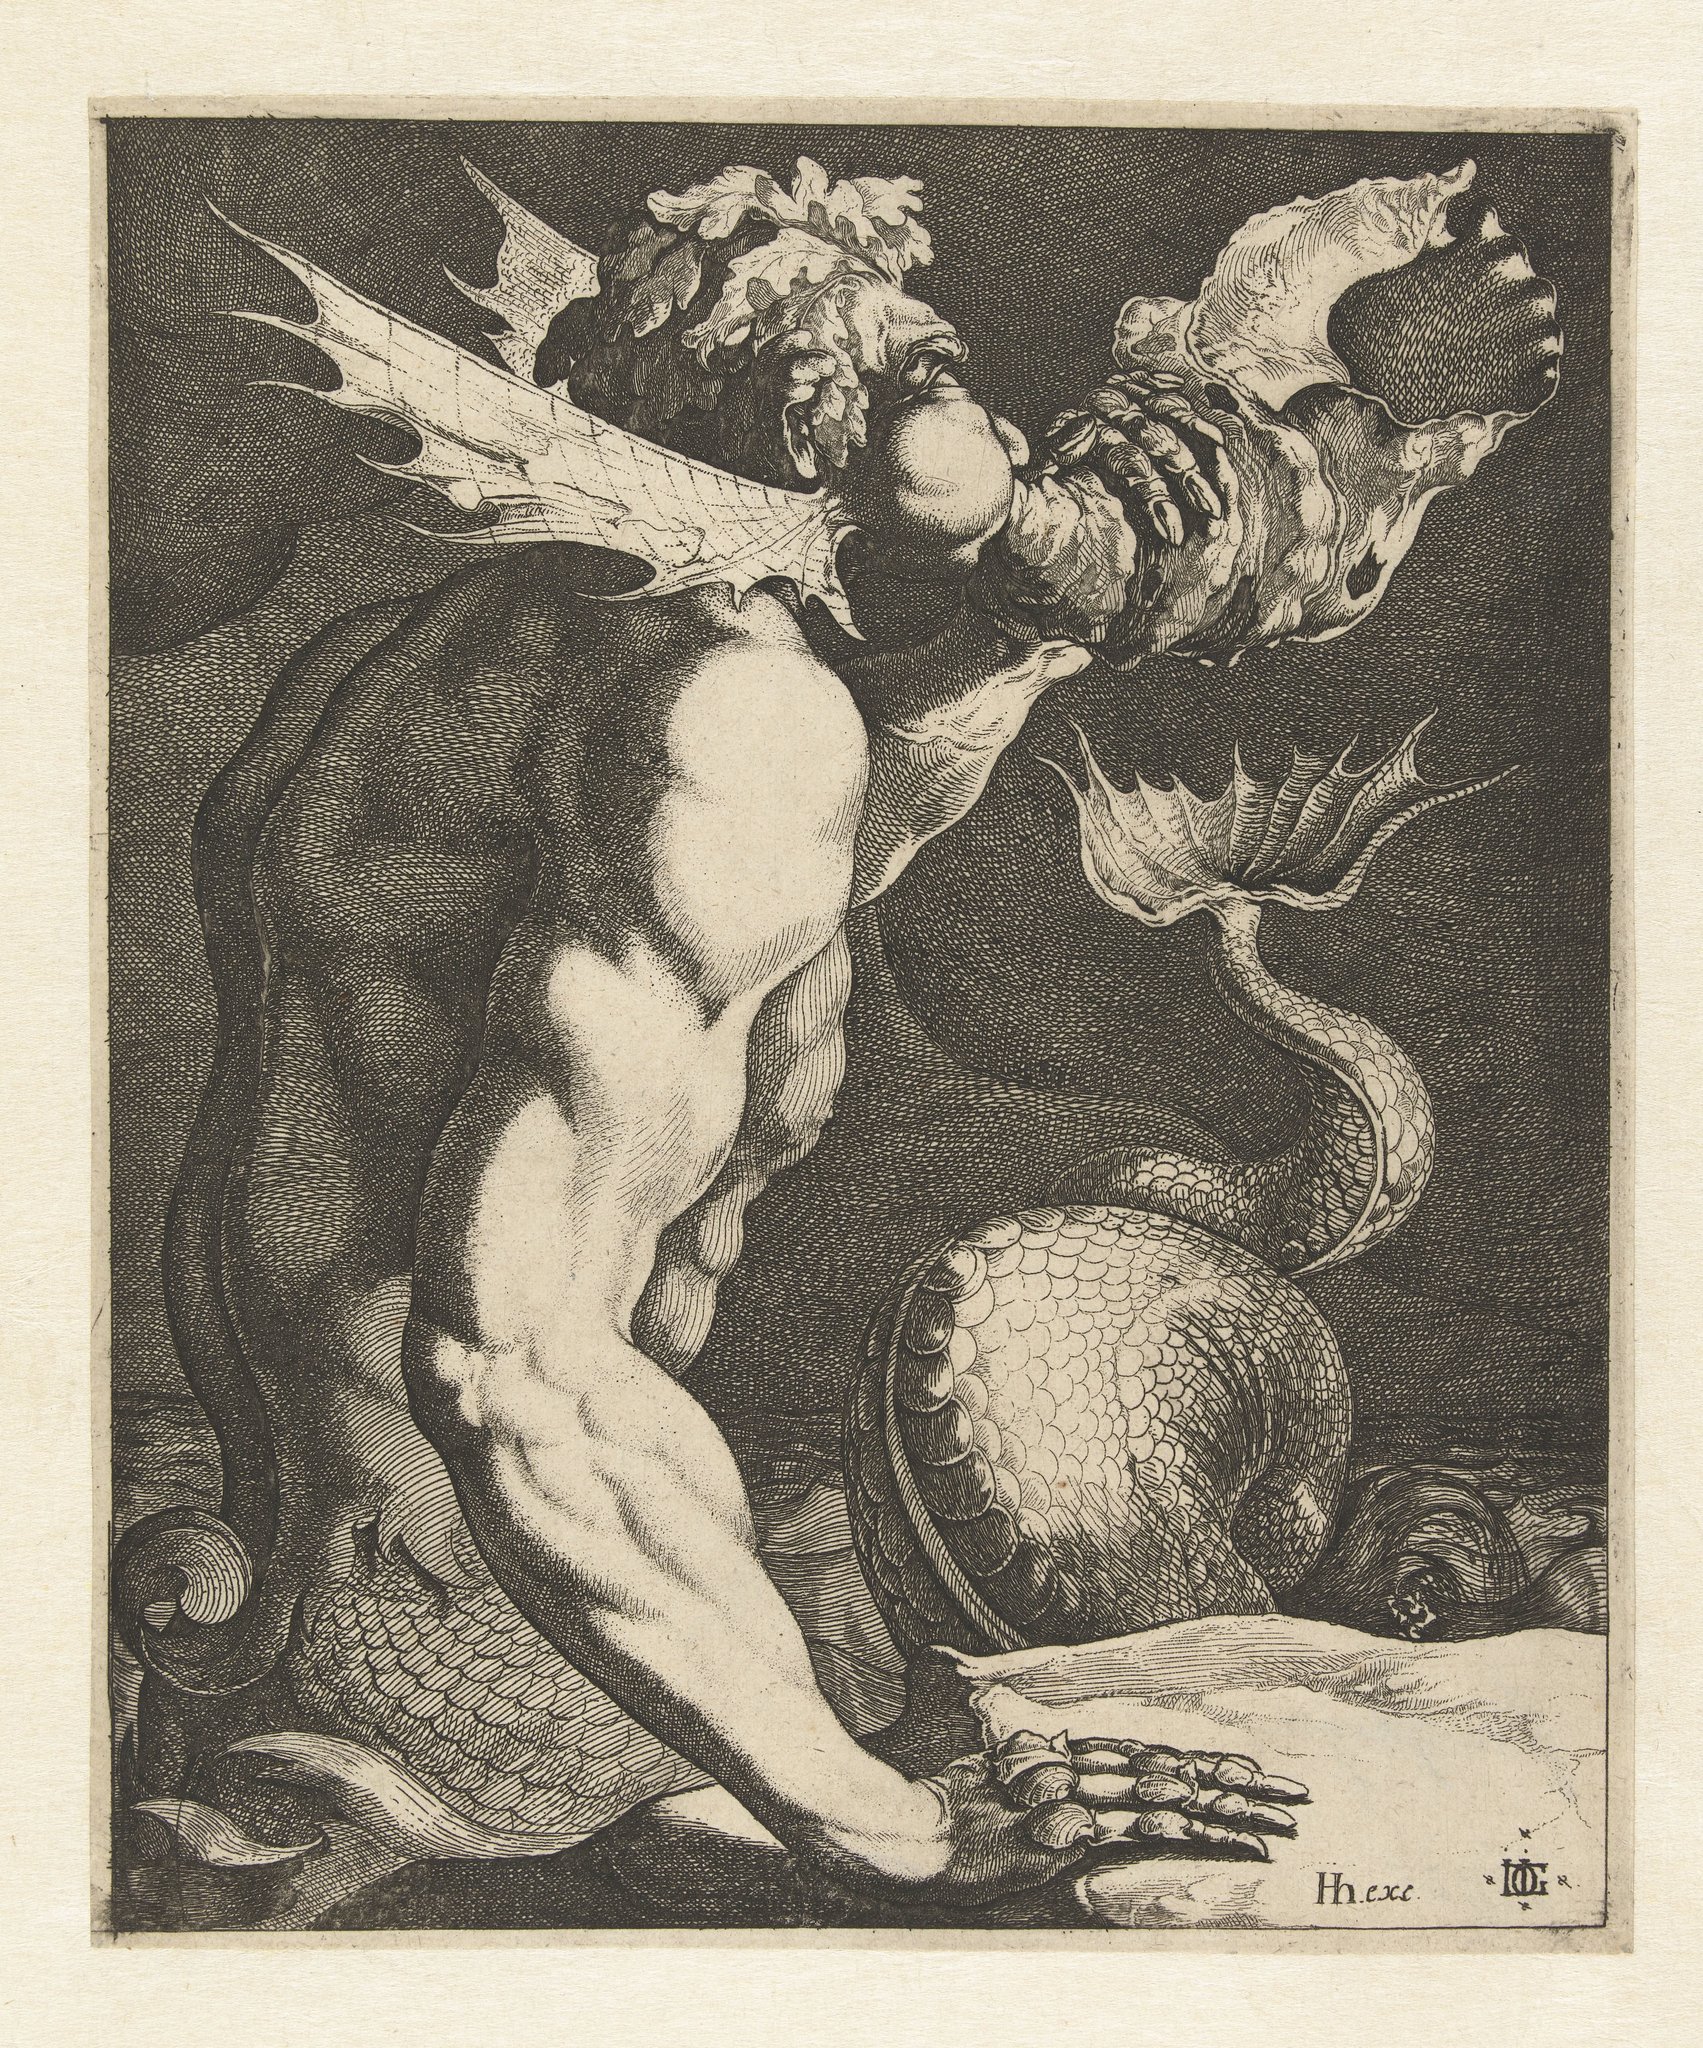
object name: print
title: Een triton die op een schelp blaast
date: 1616-1620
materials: paper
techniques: etching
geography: netherlands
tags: triton(s), triton blows on a twisted sea shell to raise or calm the waves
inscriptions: collector's mark: Lugt 2228a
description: Een triton (meerman: half vis, half man), ten halven lijve, met opvallende vinnen bij de oren, blazend op een schelp.